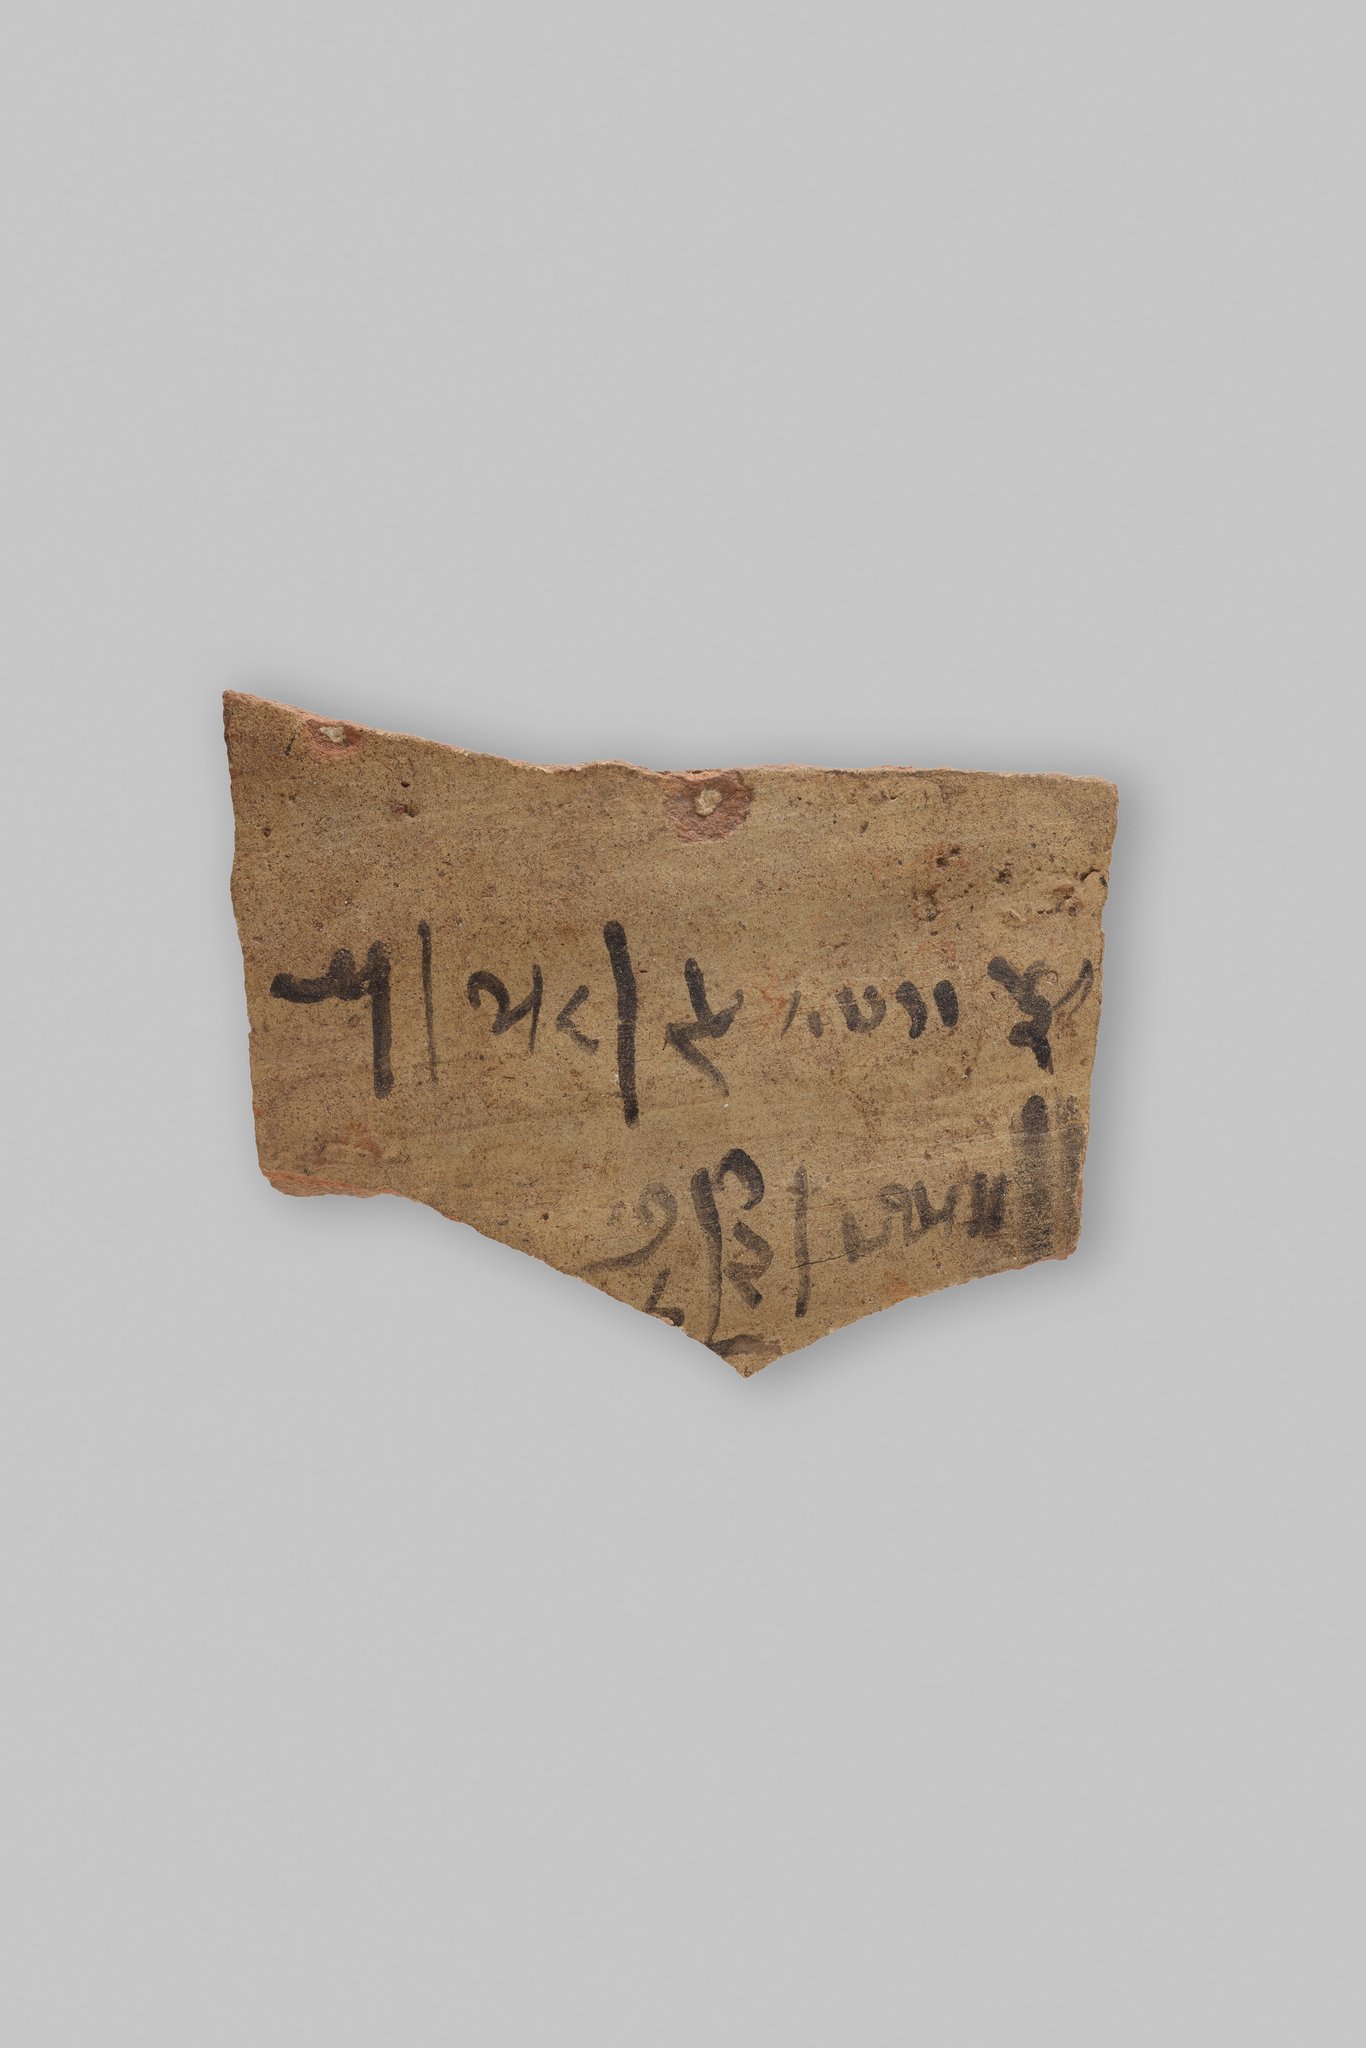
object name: ostracon, demotic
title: Ostracon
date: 600-30 BCE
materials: ink, pottery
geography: egypt